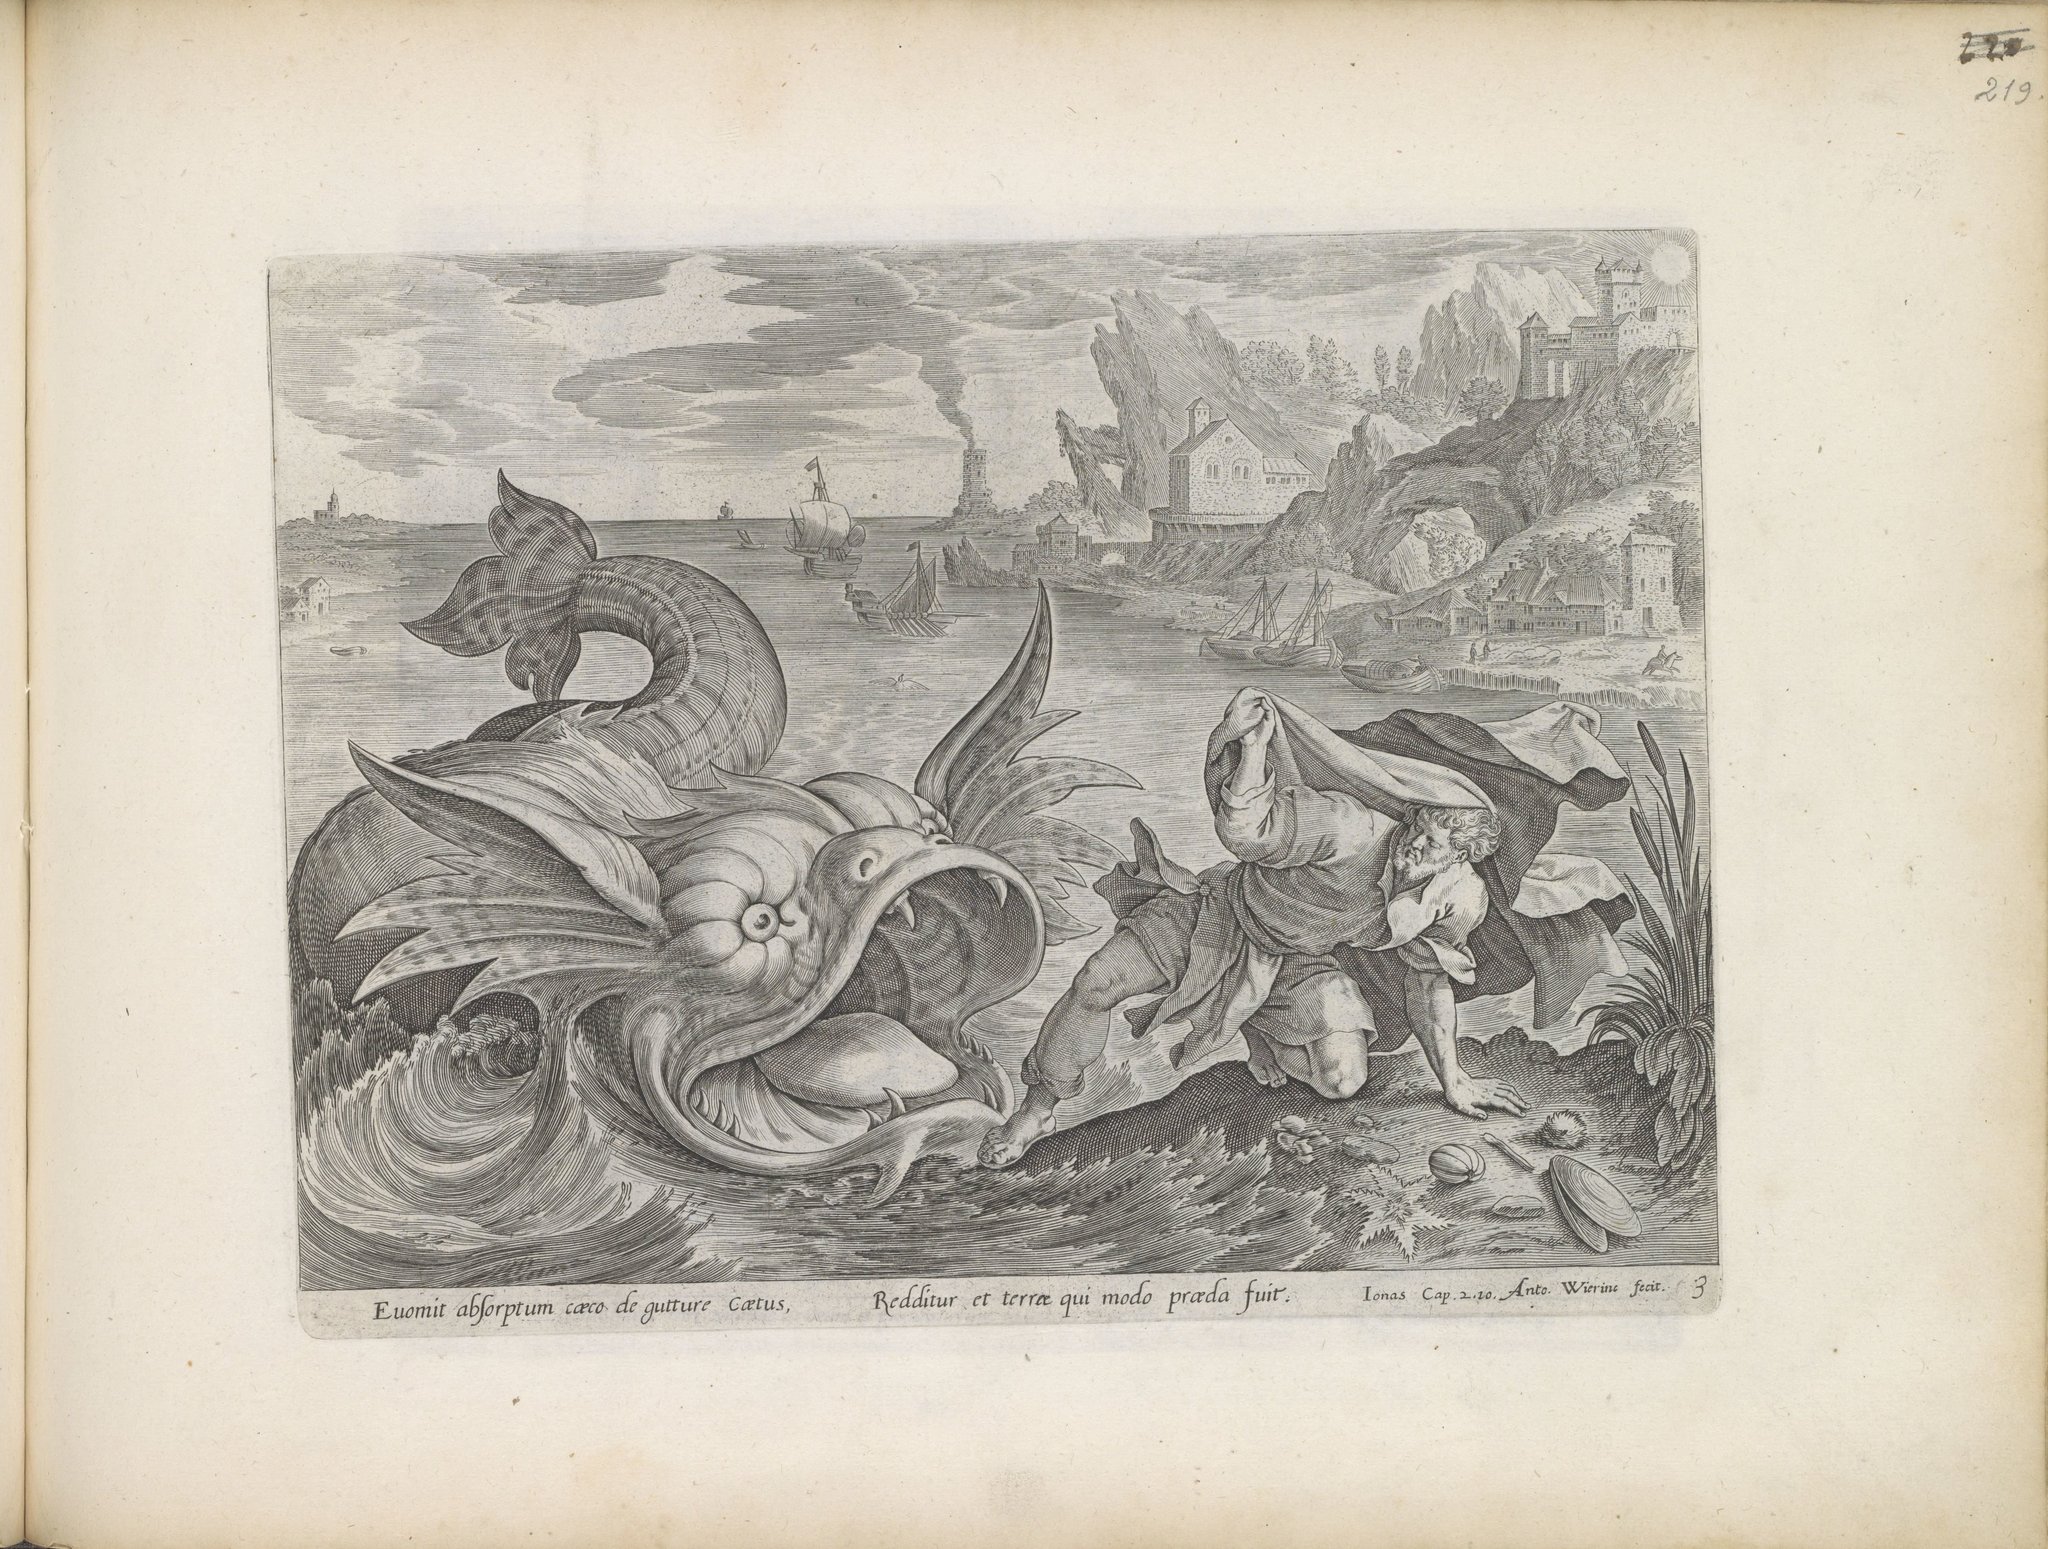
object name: album leaf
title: Geschiedenis van Jona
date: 1585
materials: paper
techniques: engraving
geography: amsterdam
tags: after a three-day sojourn in the belly of the monster jonah is cast on dry land; jonah may be shown nude and bald-headed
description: Na drie dagen en nachten in de buik van de vis overleefd te hebben spuwt de vis Jona uit op het land. Onder de voorstelling een verwijzing in het Latijn naar de Bijbeltekst in Jona 2:10. Deze prent maakt deel uit van een album.